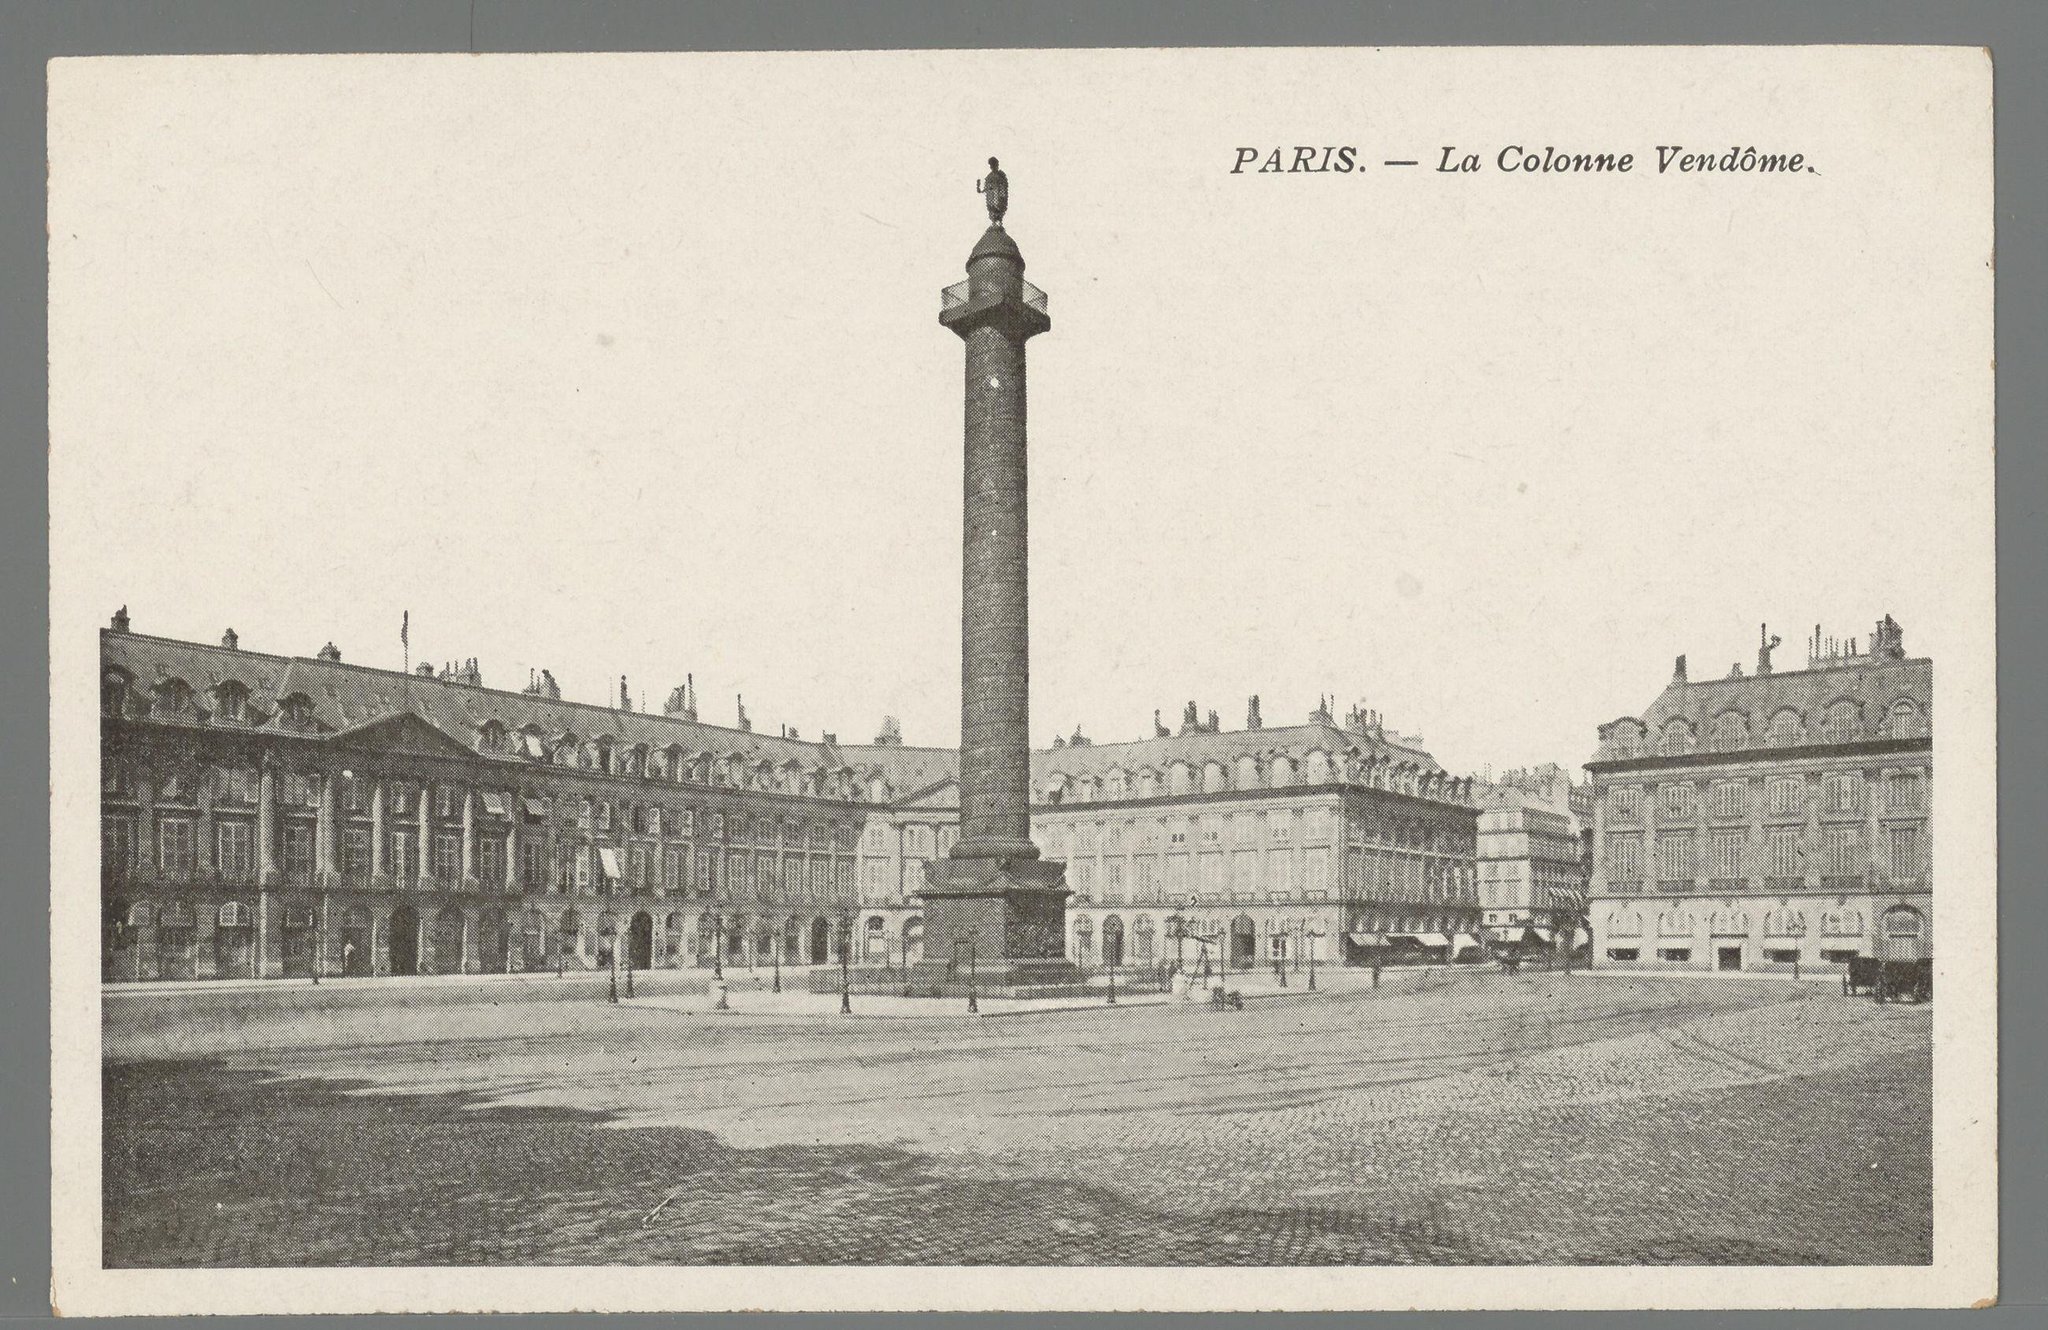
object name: photomechanical print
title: Paris. La Colonne Vendôme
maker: Anonymous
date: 1904-1906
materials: cardboard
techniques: autotype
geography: paris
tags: triumphal column with helical friezes, square, place, circus, etc. (+ city(-scape) with figures, staffage)